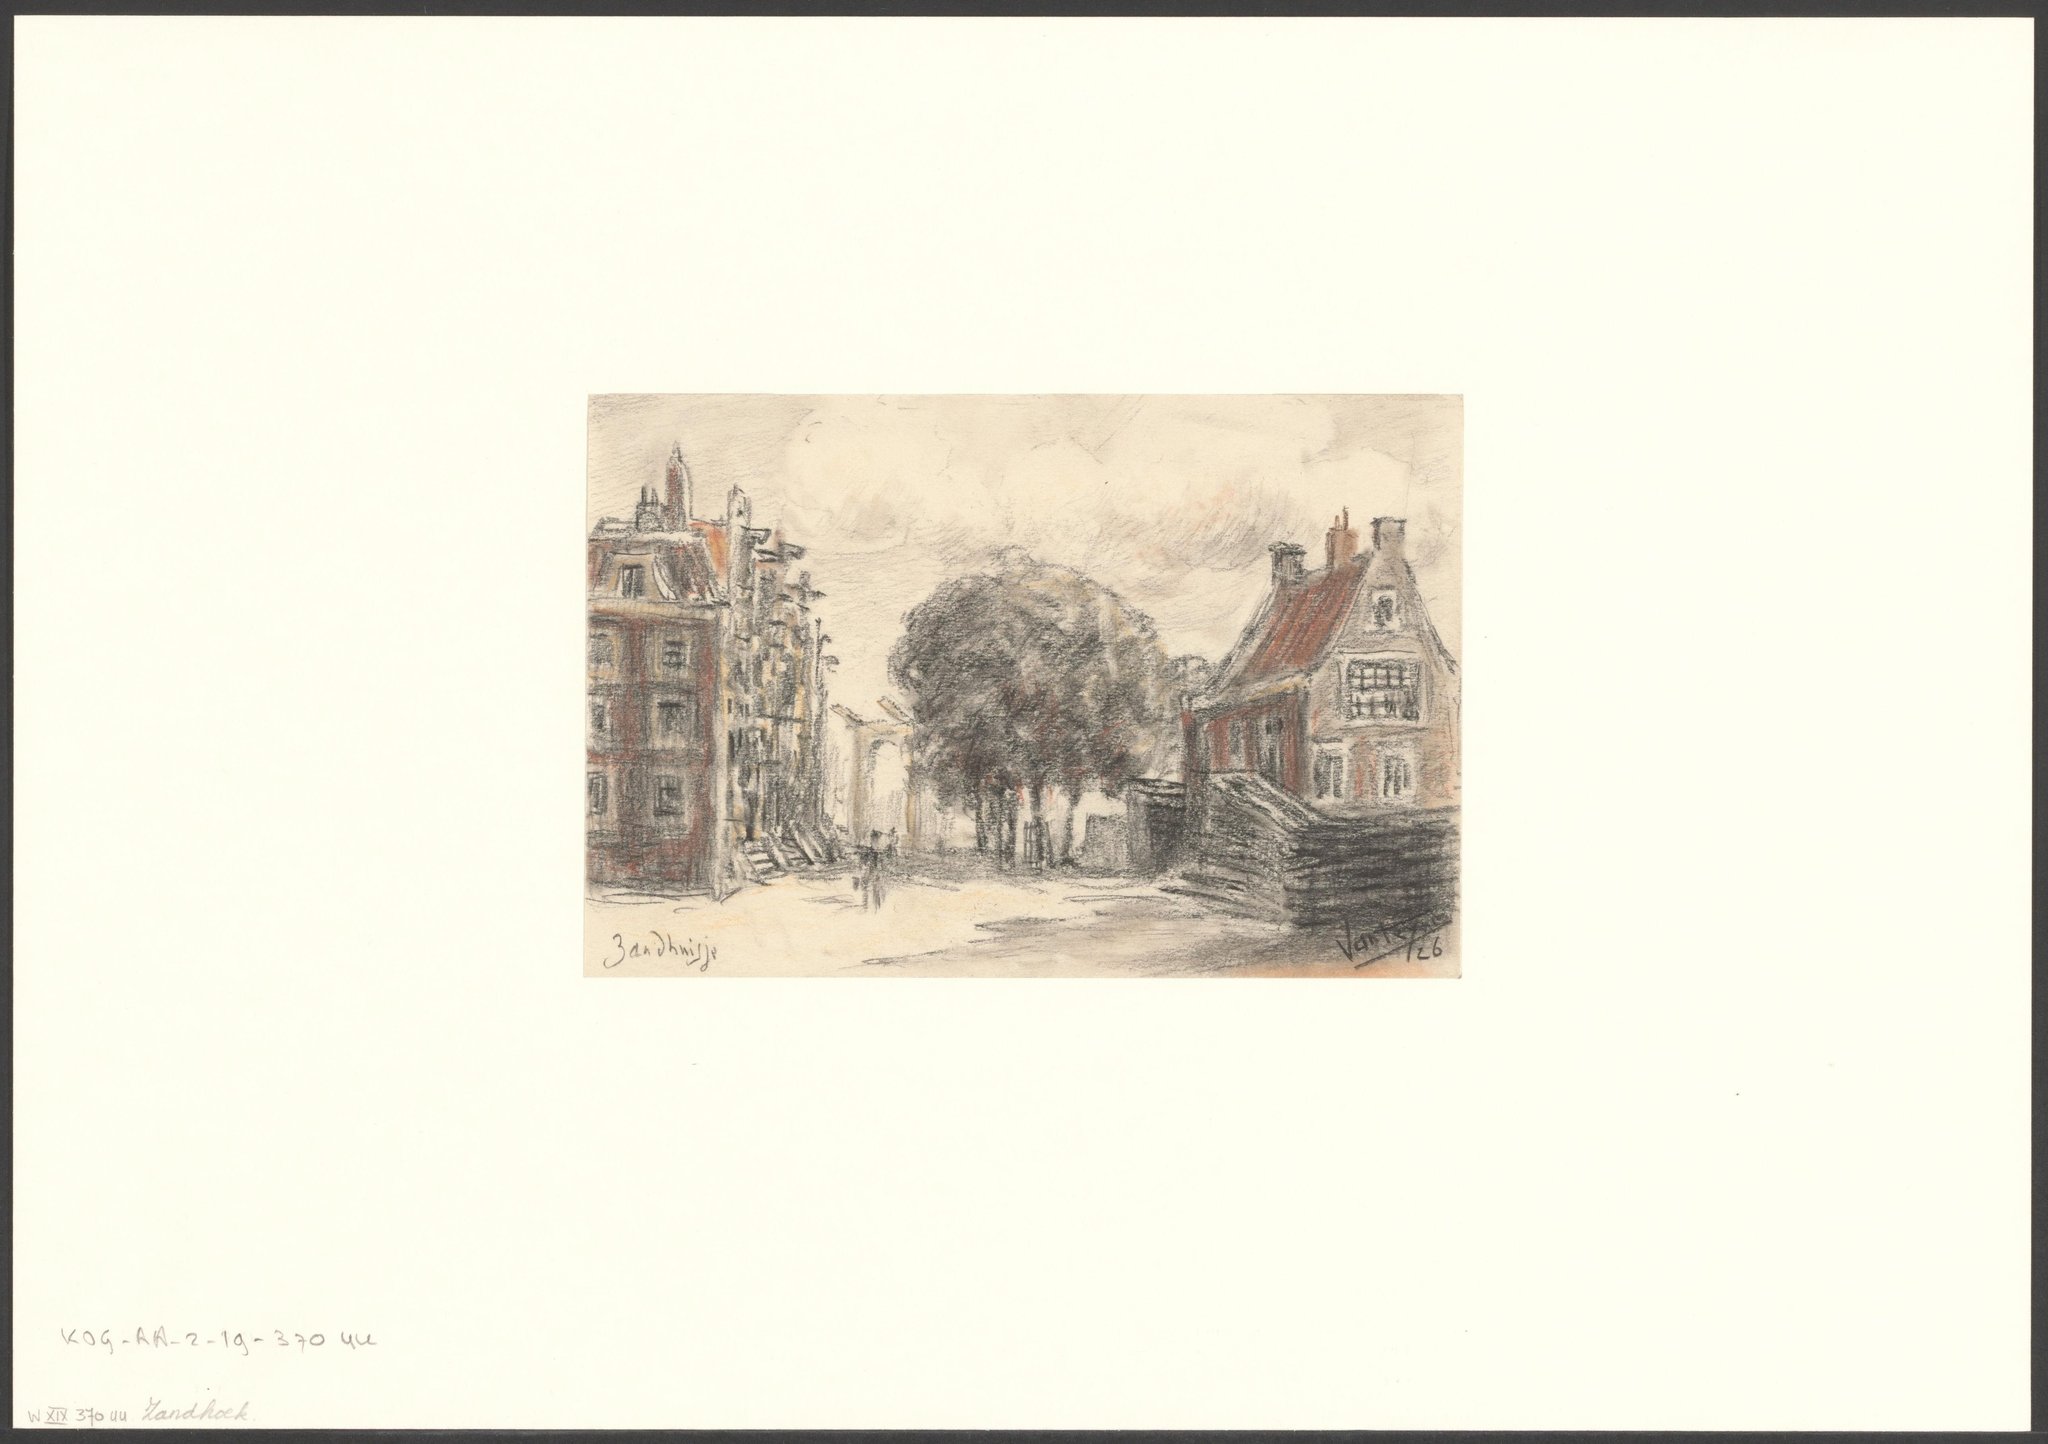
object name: drawing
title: Gezicht op de Zandhoek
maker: anthonie van teijn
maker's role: draughtsman, painter, print maker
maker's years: 1863-1943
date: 1926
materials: chalk, paper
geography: amsterdam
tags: city-view in general; 'veduta', street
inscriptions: inscription: ‘zandhuisje’, signature and date: ‘VanTeyne / 26’, stamp: ‘J. van Eck.’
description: Tekening binnen de Atlas Van Eck ingedeeld op wijknummer 19.